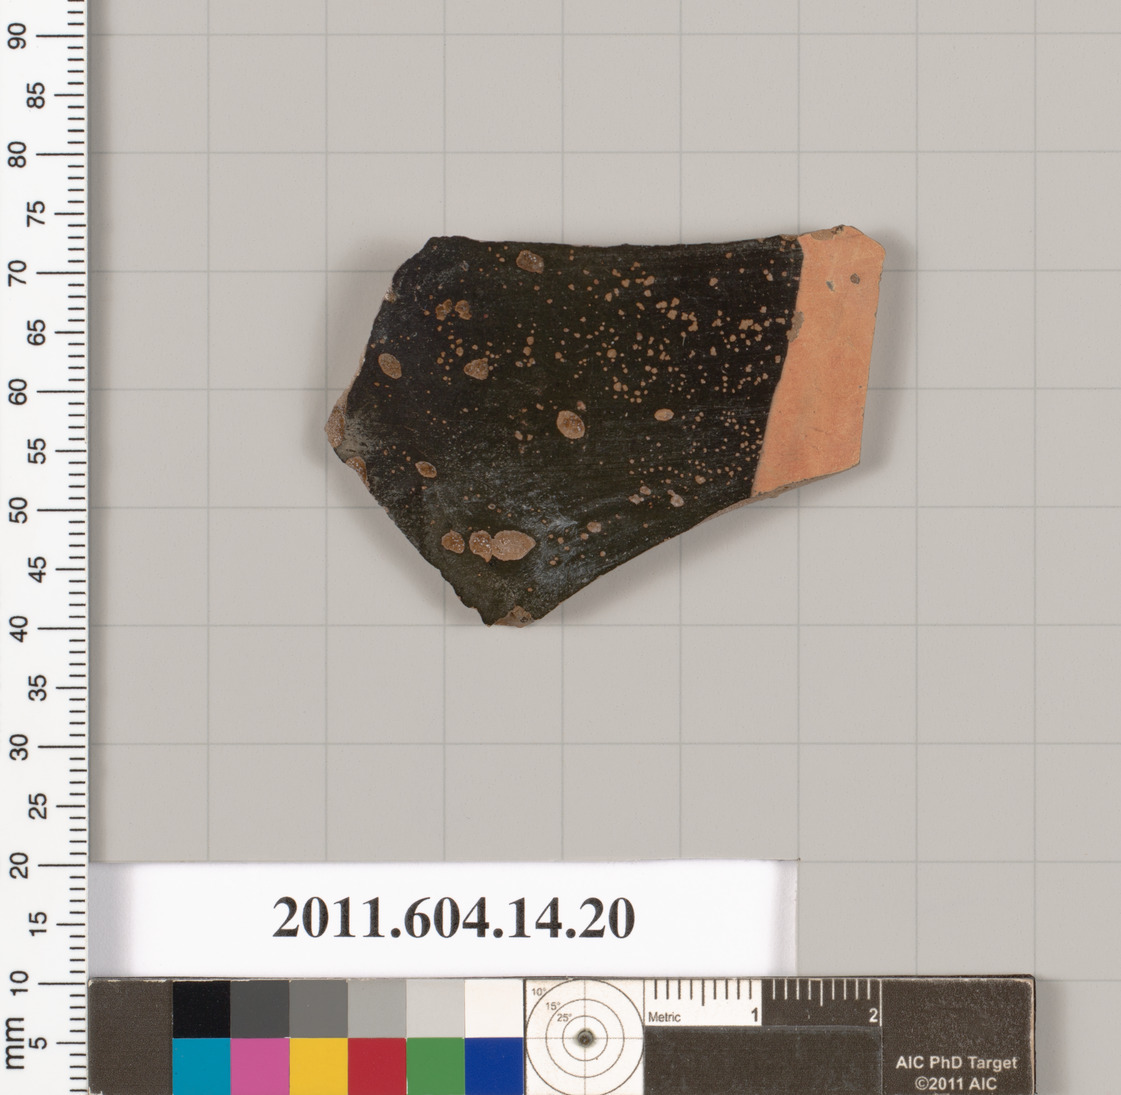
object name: undetermined closed shape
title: Terracotta fragment of an undetermined closed shape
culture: unknown fabric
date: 600-501 BCE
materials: terracotta